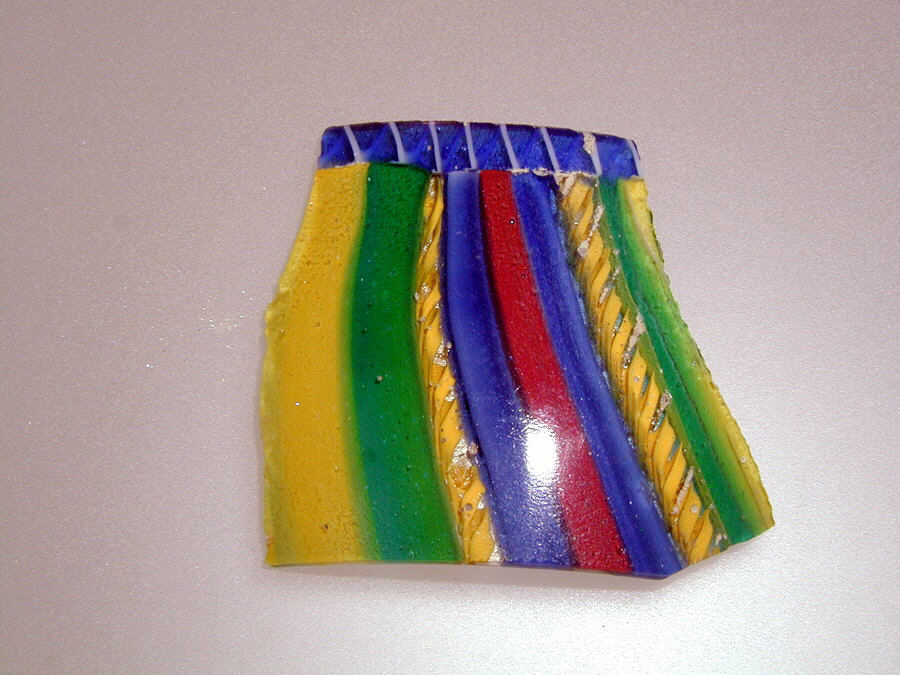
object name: fragment, striped mosaic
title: Glass striped mosaic bowl fragment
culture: roman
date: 34 BCE-33 CE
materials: glass